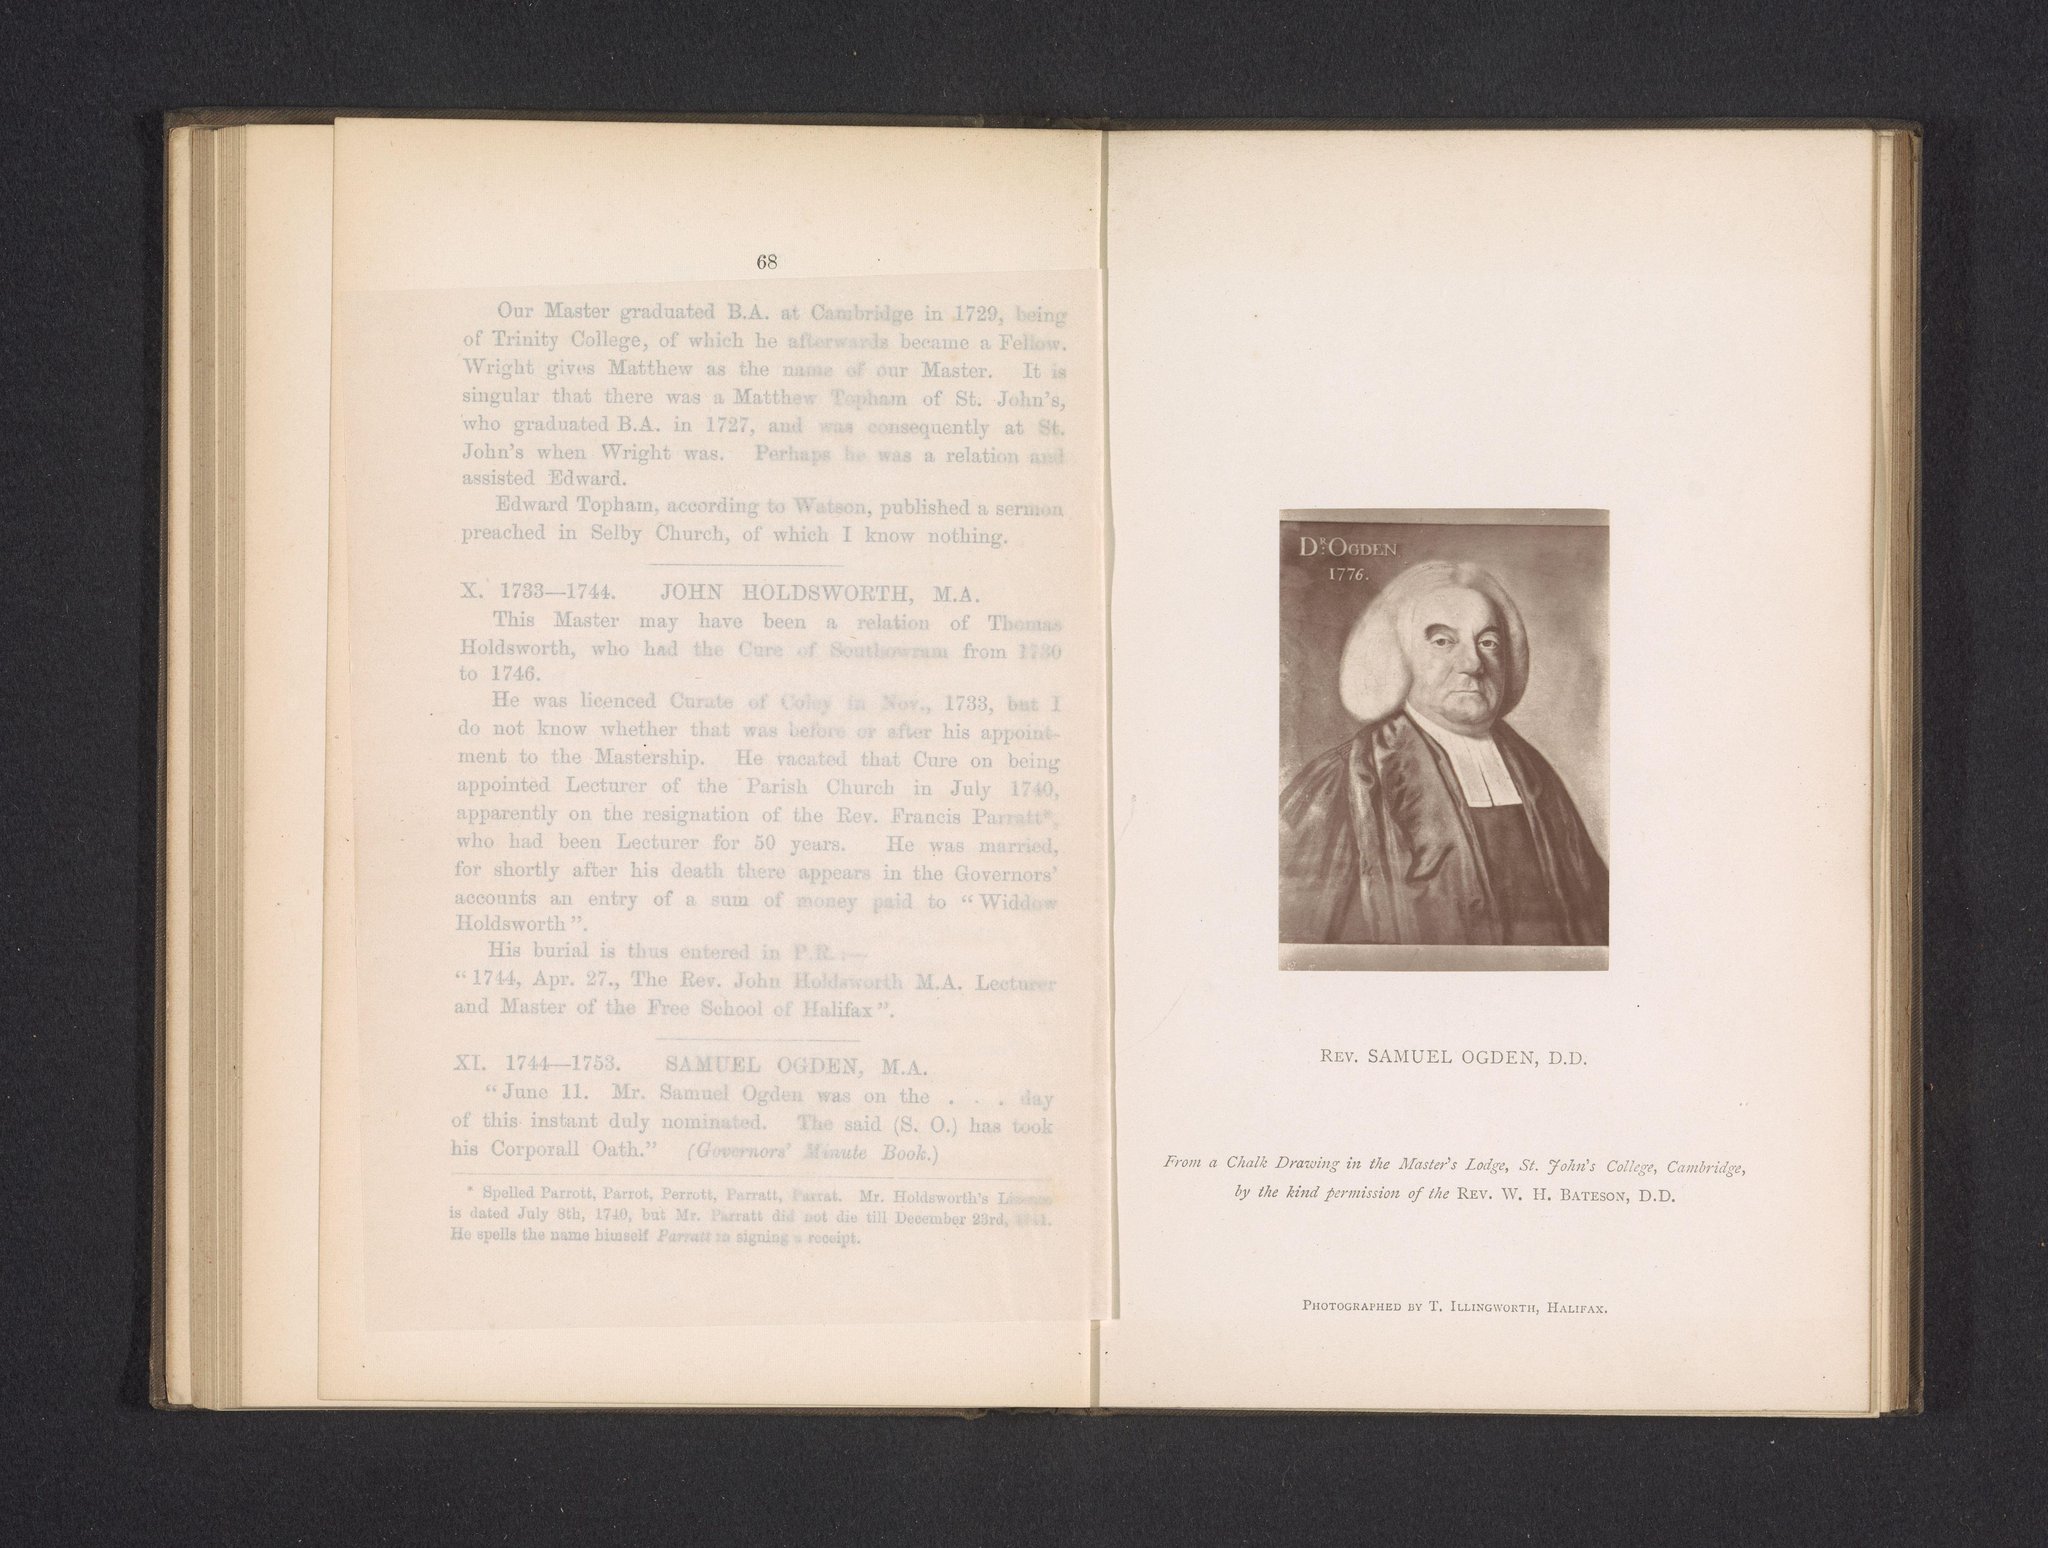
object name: page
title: Fotoreproductie van een portret van Samuel Ogden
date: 1869-1879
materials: paper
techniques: woodburytype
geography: halifax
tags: functionaries and dignitaries (with name) ~ protestant churches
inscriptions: inscription: ‘From a Chalk Drawing in the Master's Lodge, St. John's College, Cambridge, by the kind permission of Rev. W.H. Bateson, D.D.’